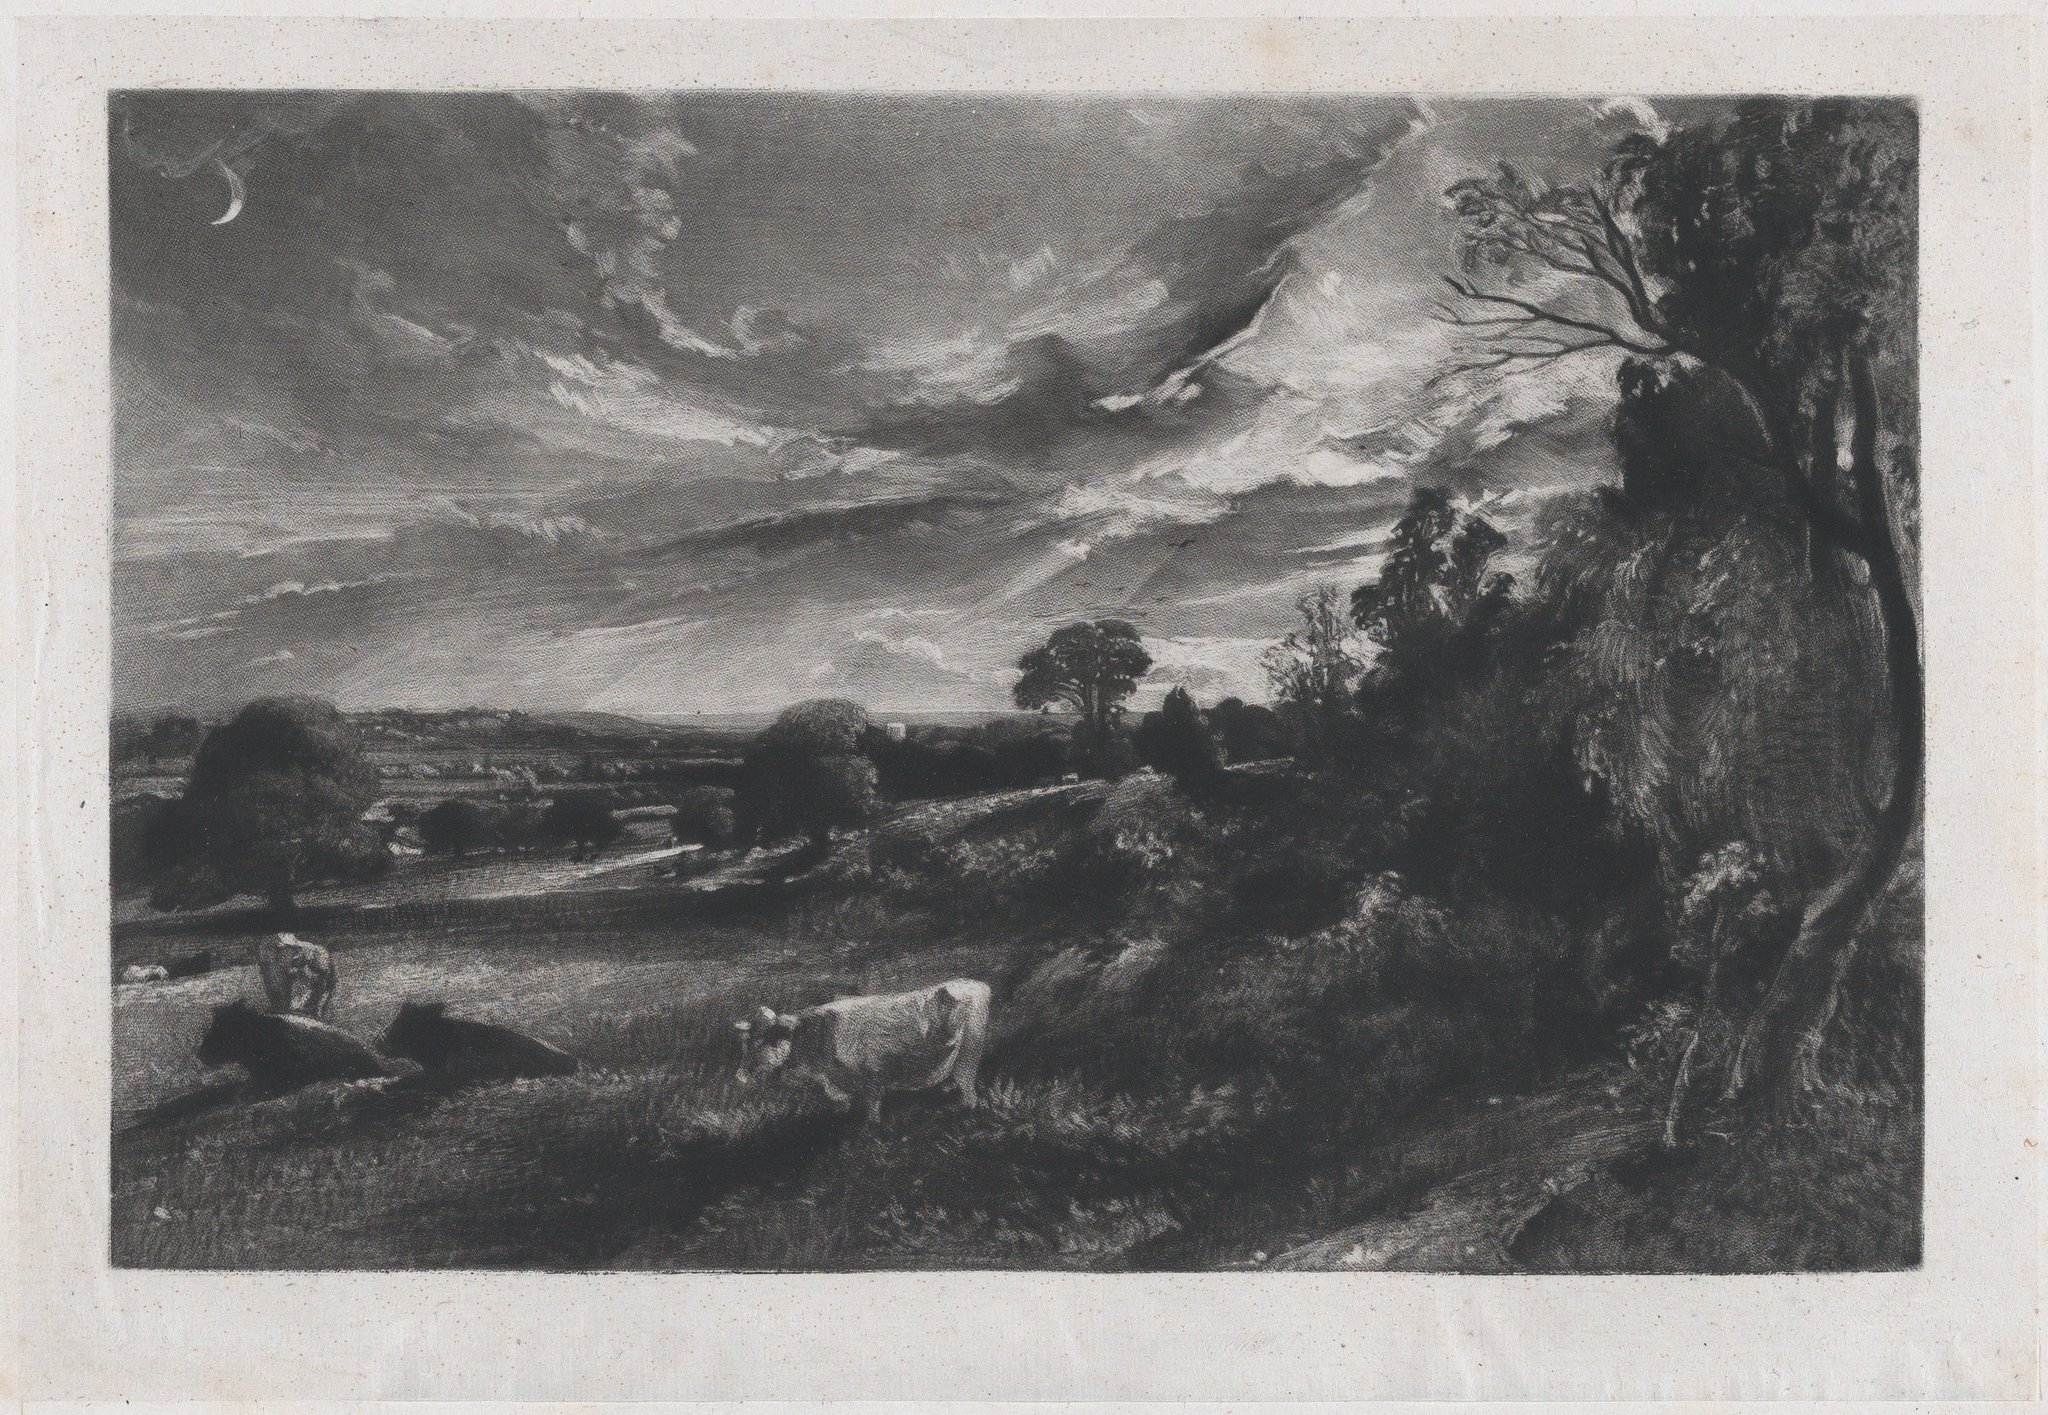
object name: print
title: Summer Evening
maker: david lucas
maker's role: artist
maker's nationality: british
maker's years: 1802-1881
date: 1829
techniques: printmaking, mezzotint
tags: cows,landscapes,summer,evening